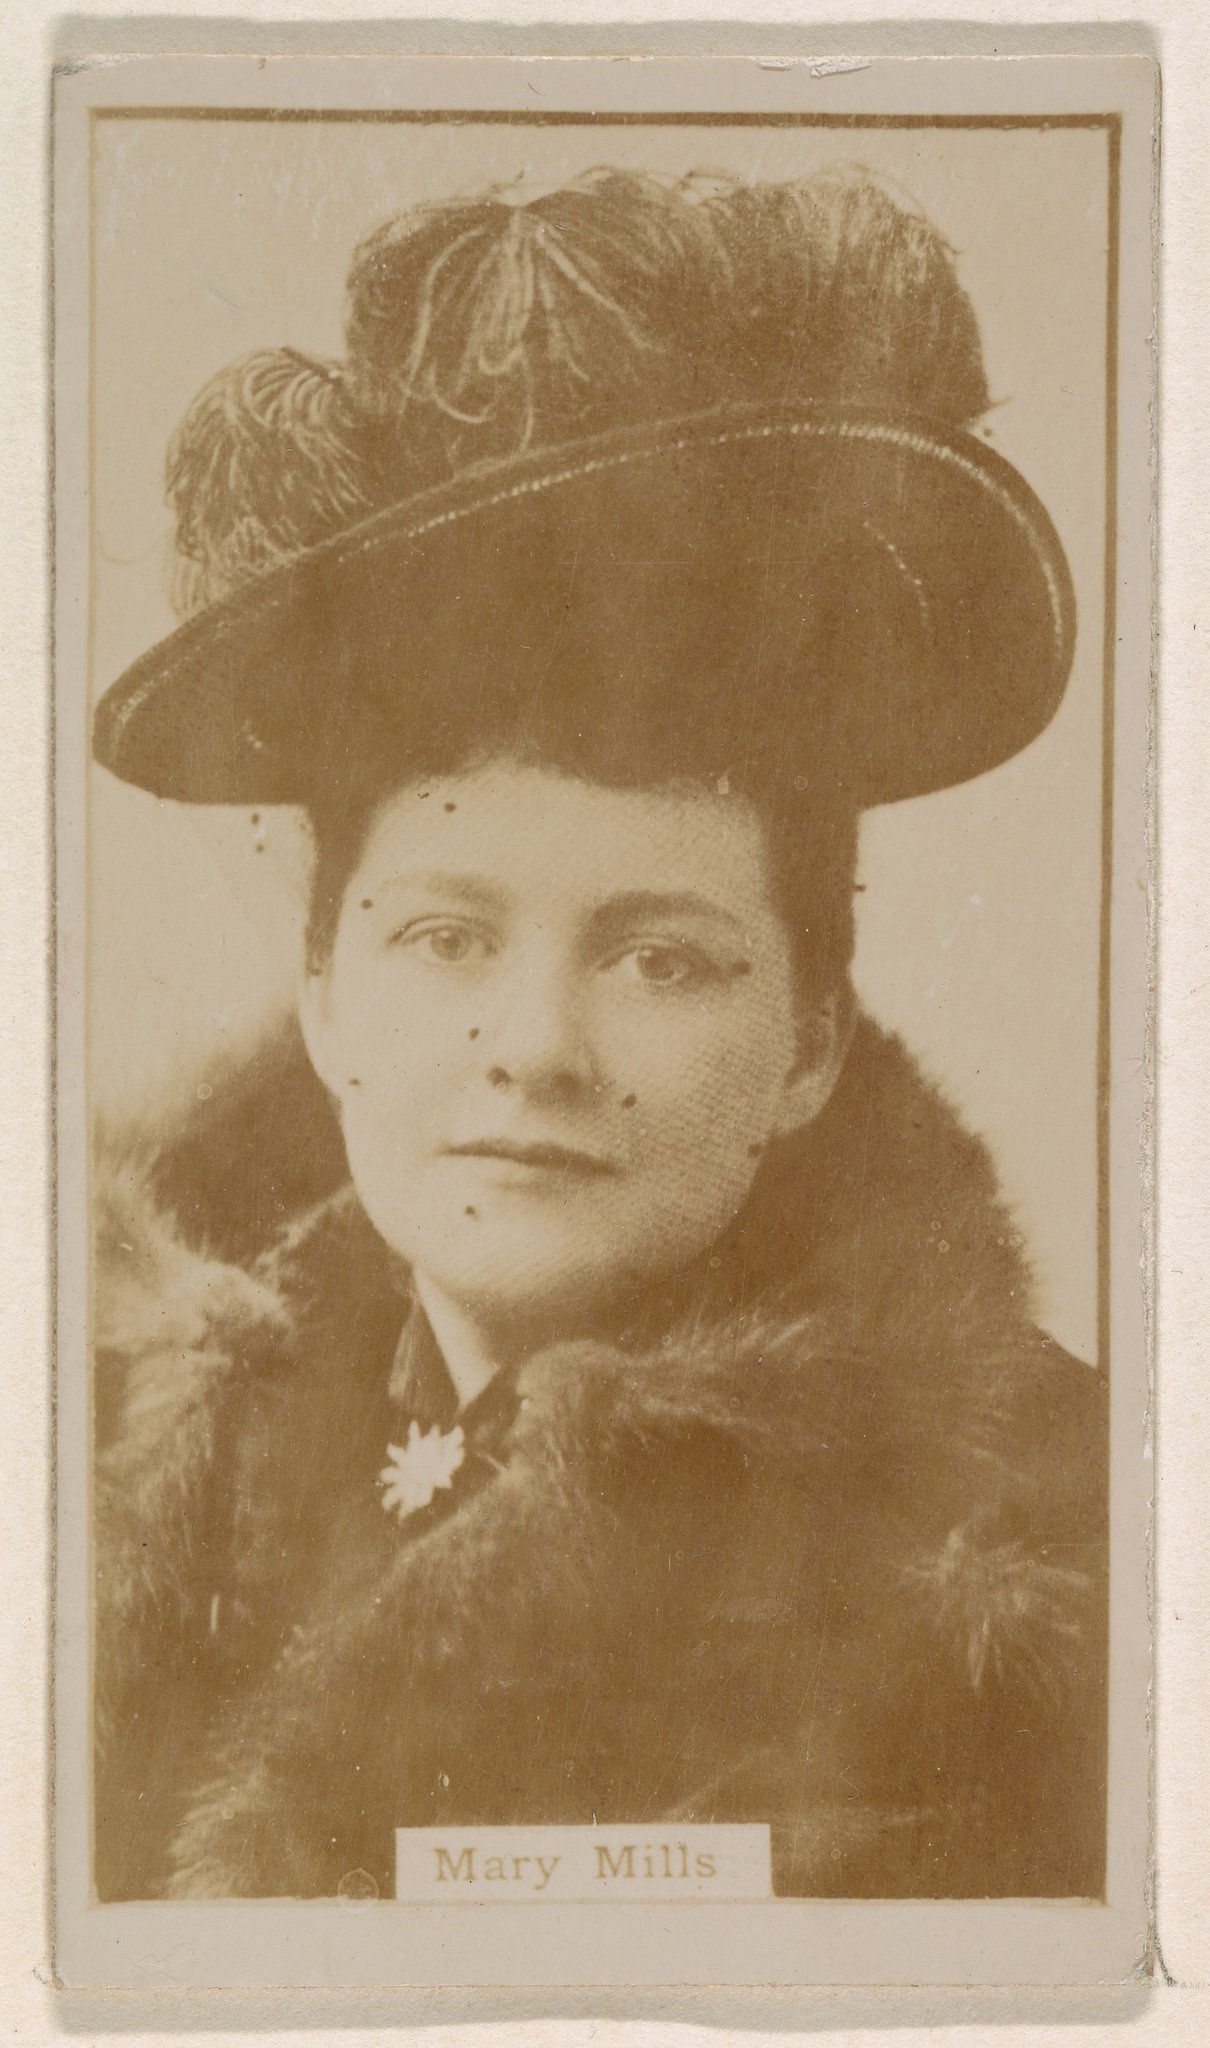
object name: photograph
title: Mary Mills, from the Actresses series (N245) issued by Kinney Brothers to promote Sweet Caporal Cigarettes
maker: kinney brothers tobacco company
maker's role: publisher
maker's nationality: american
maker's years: 1869-2011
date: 1890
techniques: albumen silver print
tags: portraits,women,actresses